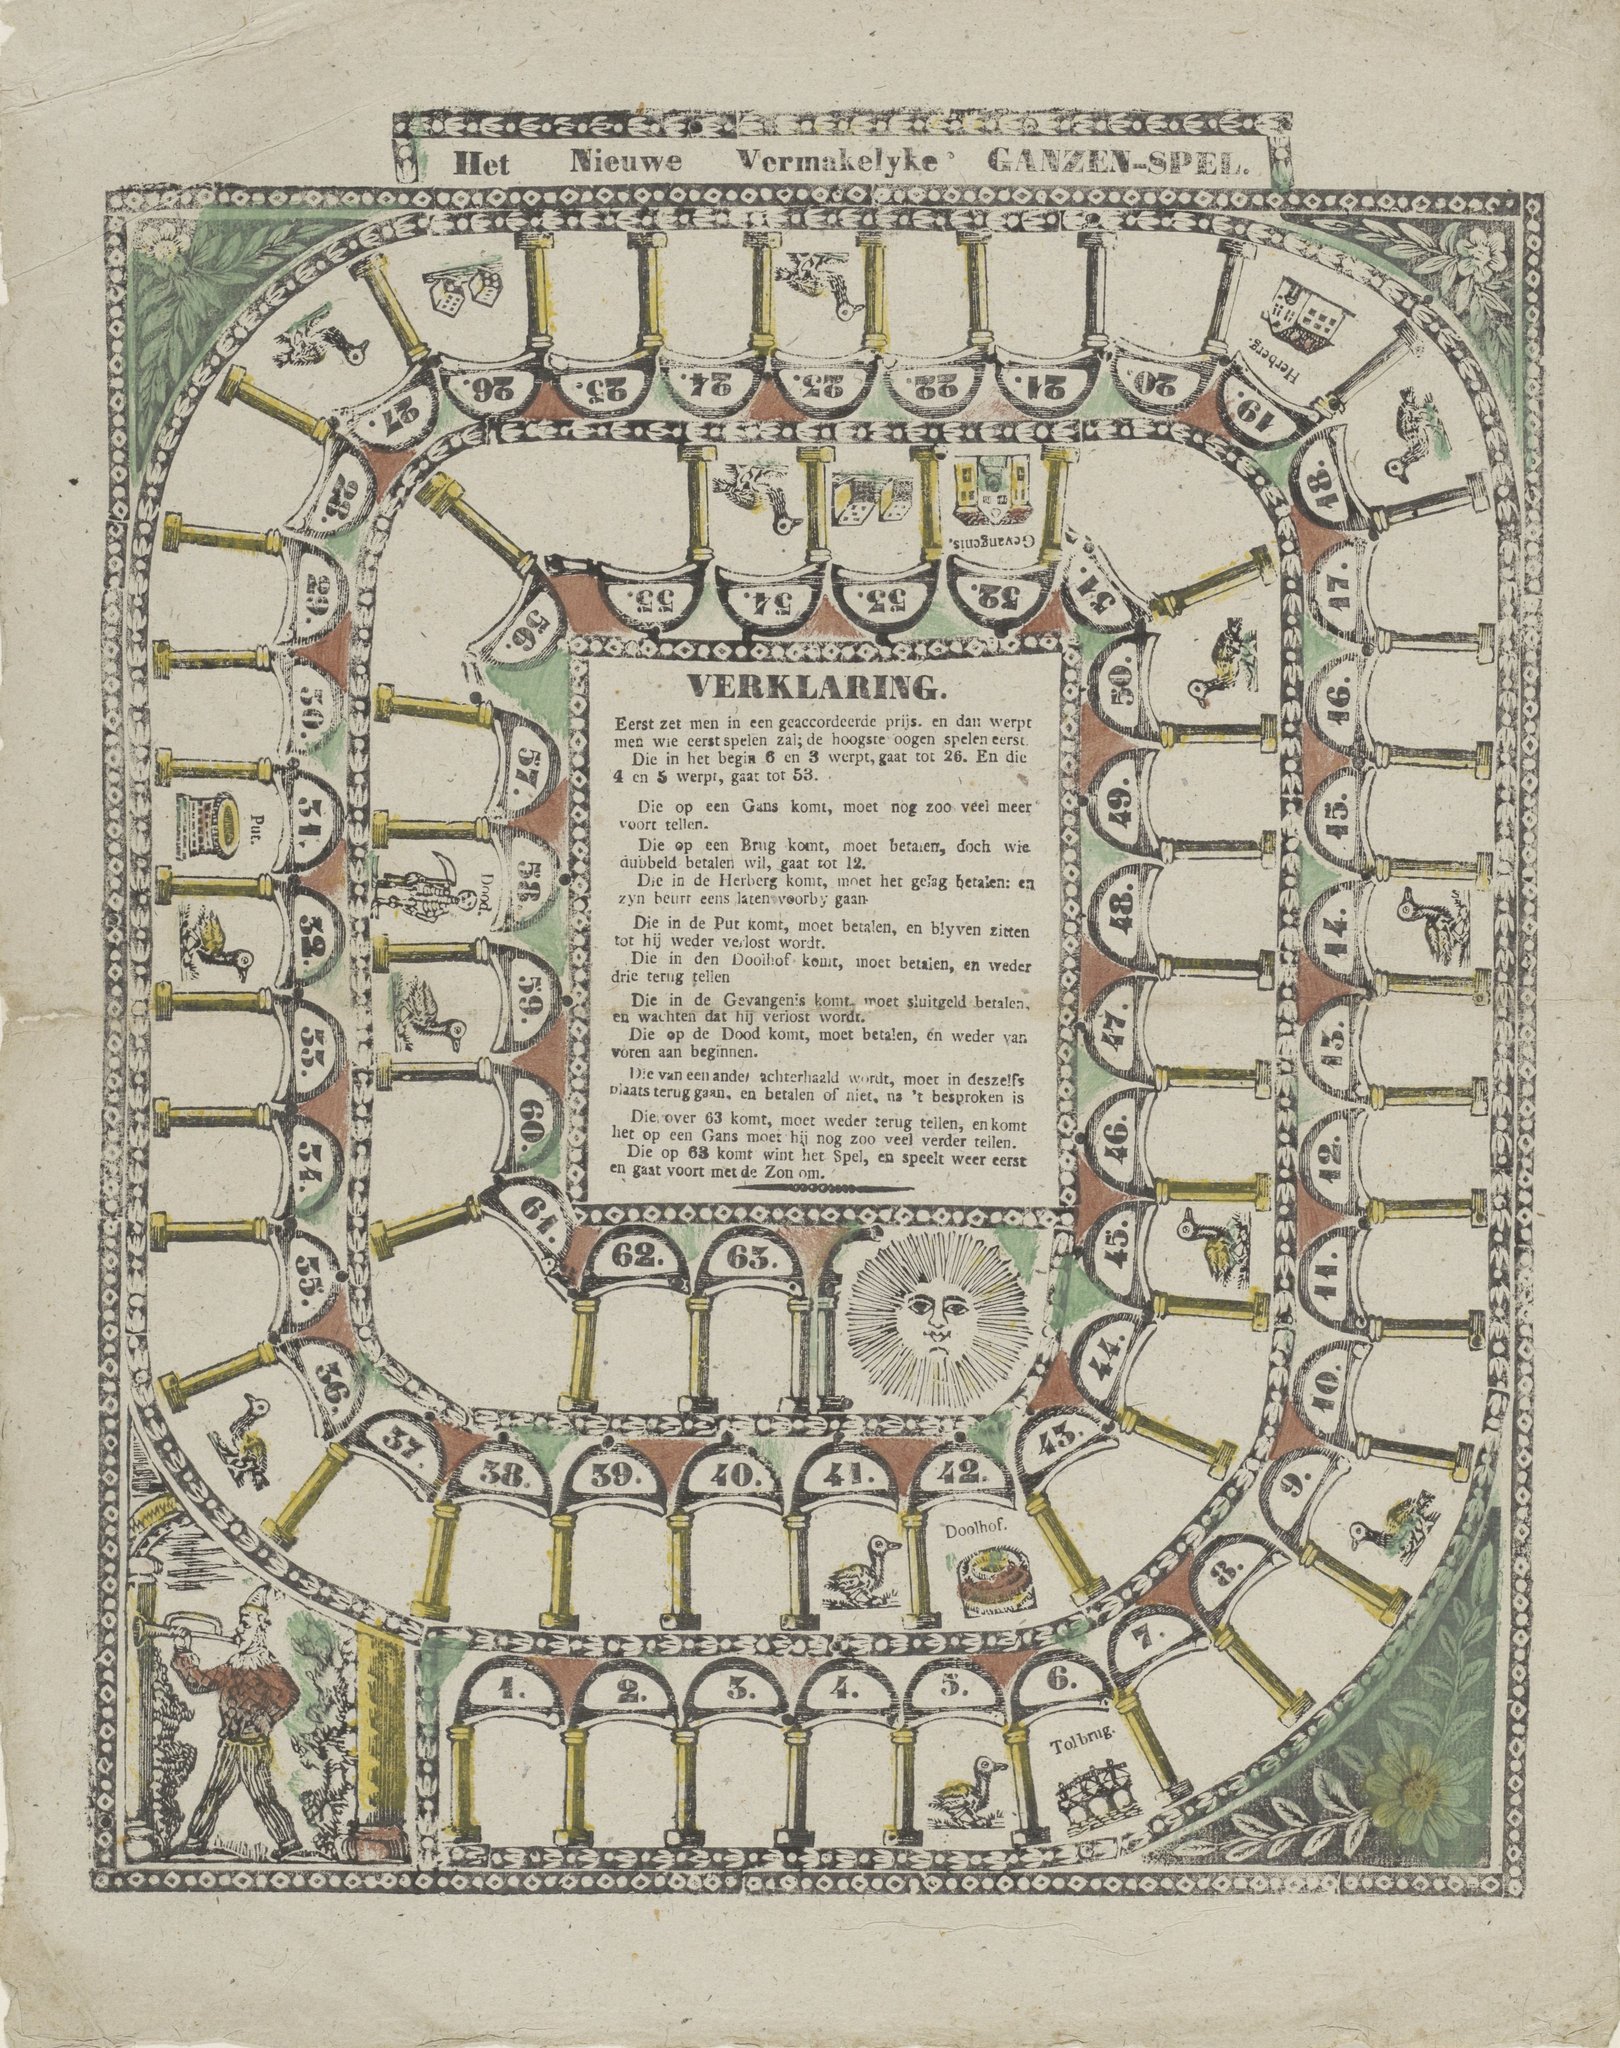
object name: print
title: Het nieuwe vermakelyke ganzen-spel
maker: Anonymous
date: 1700-1899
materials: paper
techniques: colour, letterpress printing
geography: netherlands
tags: goose-game, board-games of chance, board-games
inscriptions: collector's mark: Lugt 2760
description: Ganzenbordspel met vakjes genummerd van 1 tot en met 63. In enkele vakjes voorstellingen van ganzen. In het grote centrale vak de spelregels in boekdruk.